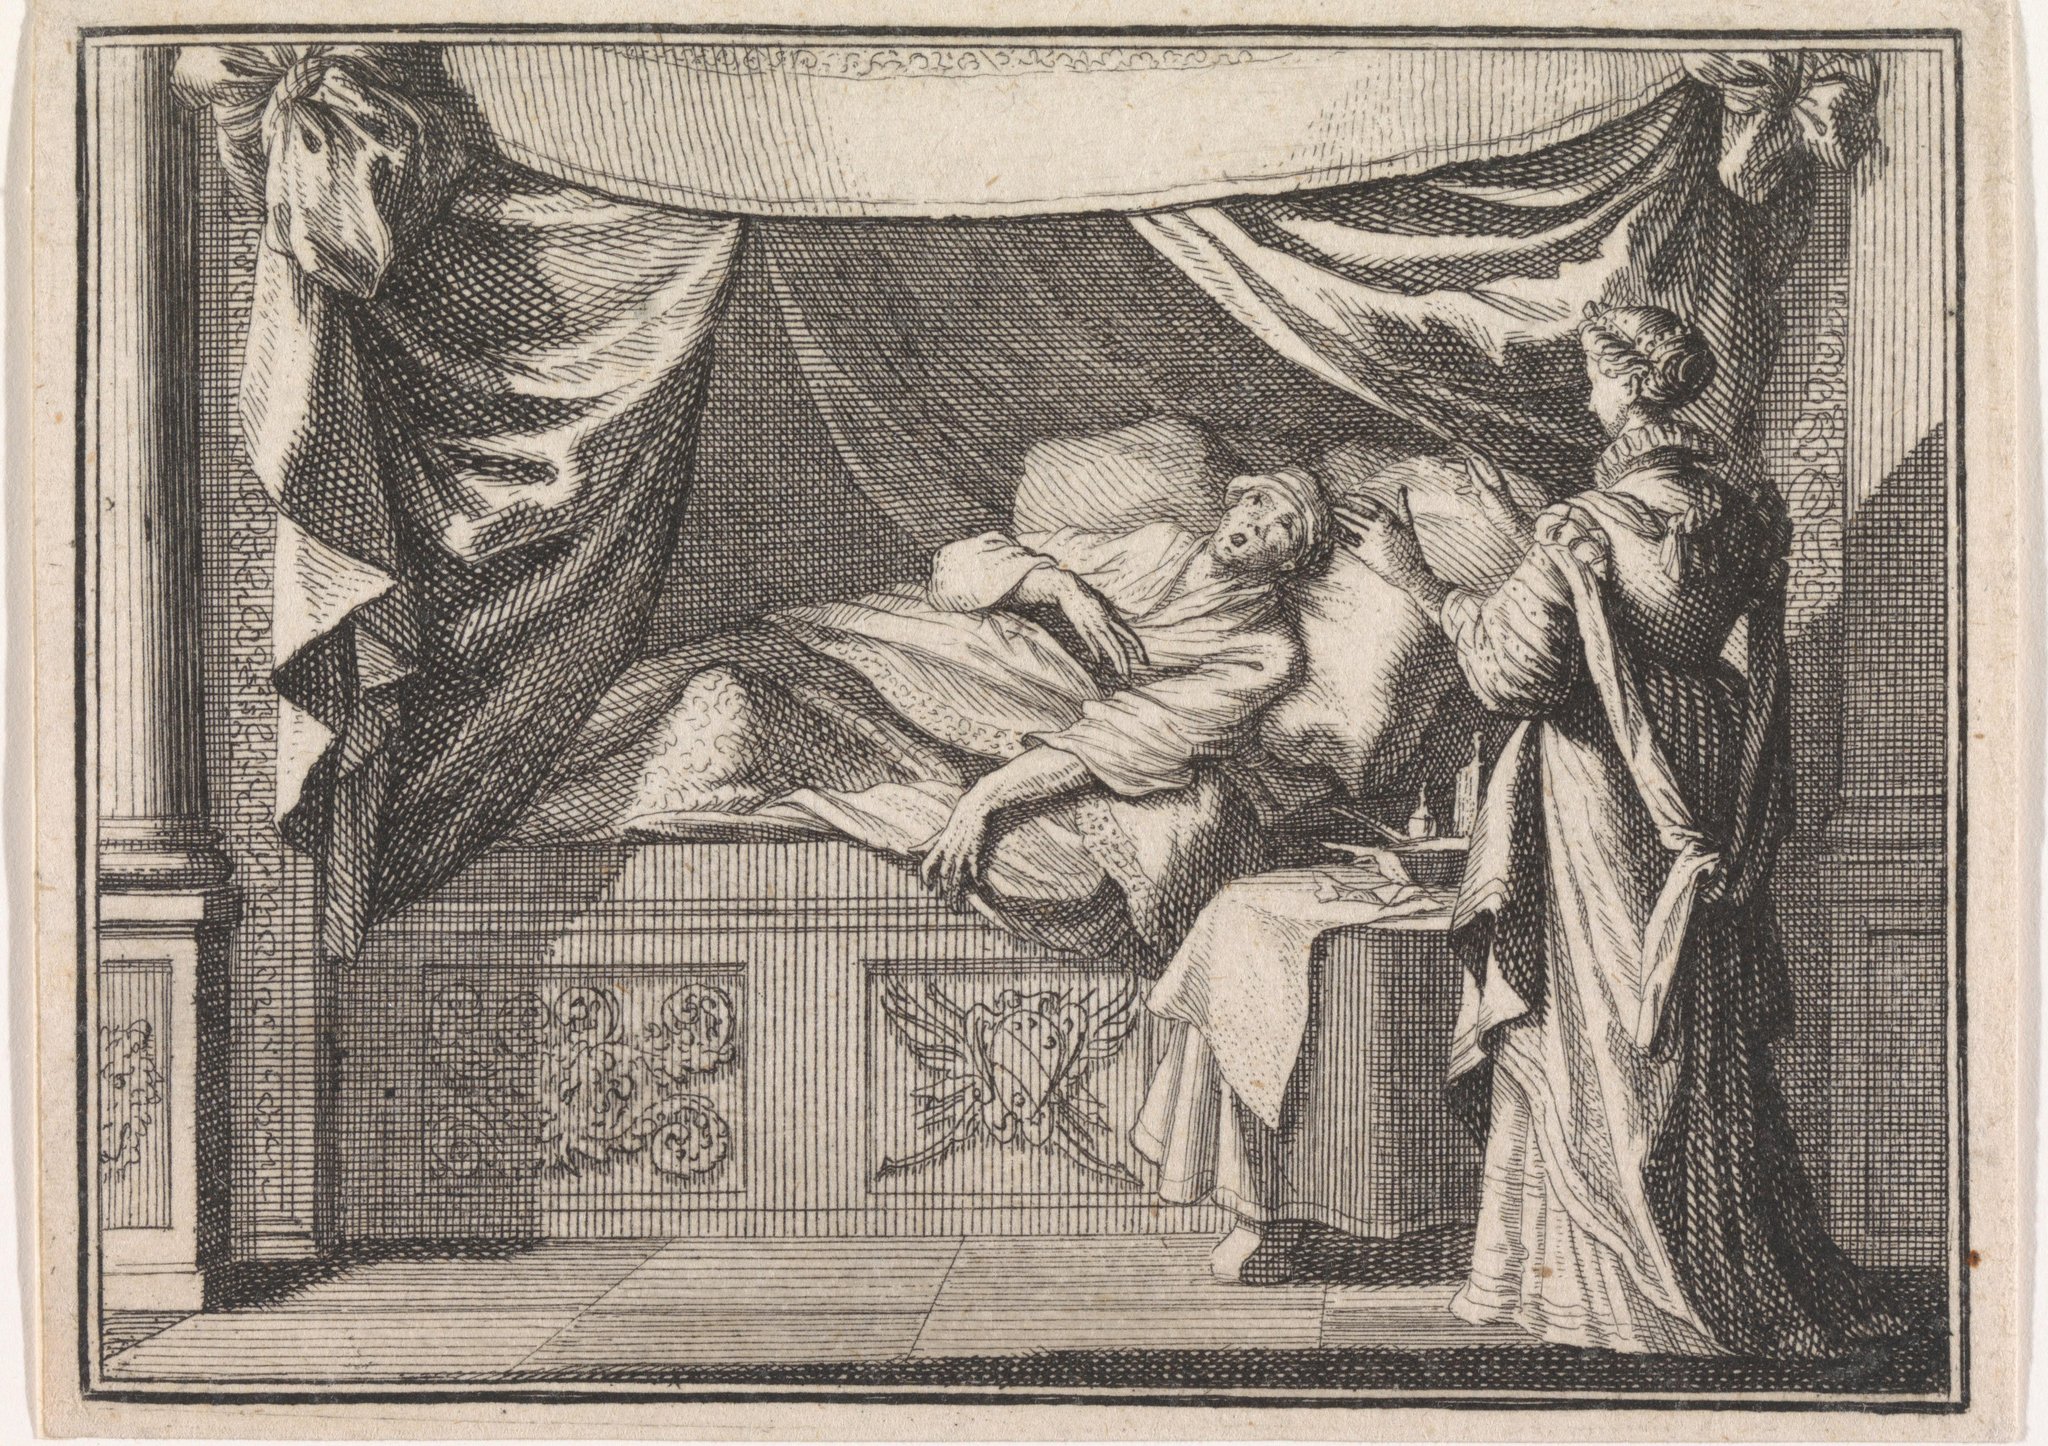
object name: print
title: Der Wider stösset manchen nieder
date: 1710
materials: paper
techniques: etching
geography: nuremberg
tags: illusion, phantasm, dying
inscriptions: collector's mark: Lugt 240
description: Illustratie uit: Abraham a Sancta Clara. Heilsames Gemisch Gemasch, das ist: Allerley seltsame und verwunderliche Geschichten (...). Neurenberg: Christoph Weigel, 1710, p. 39.